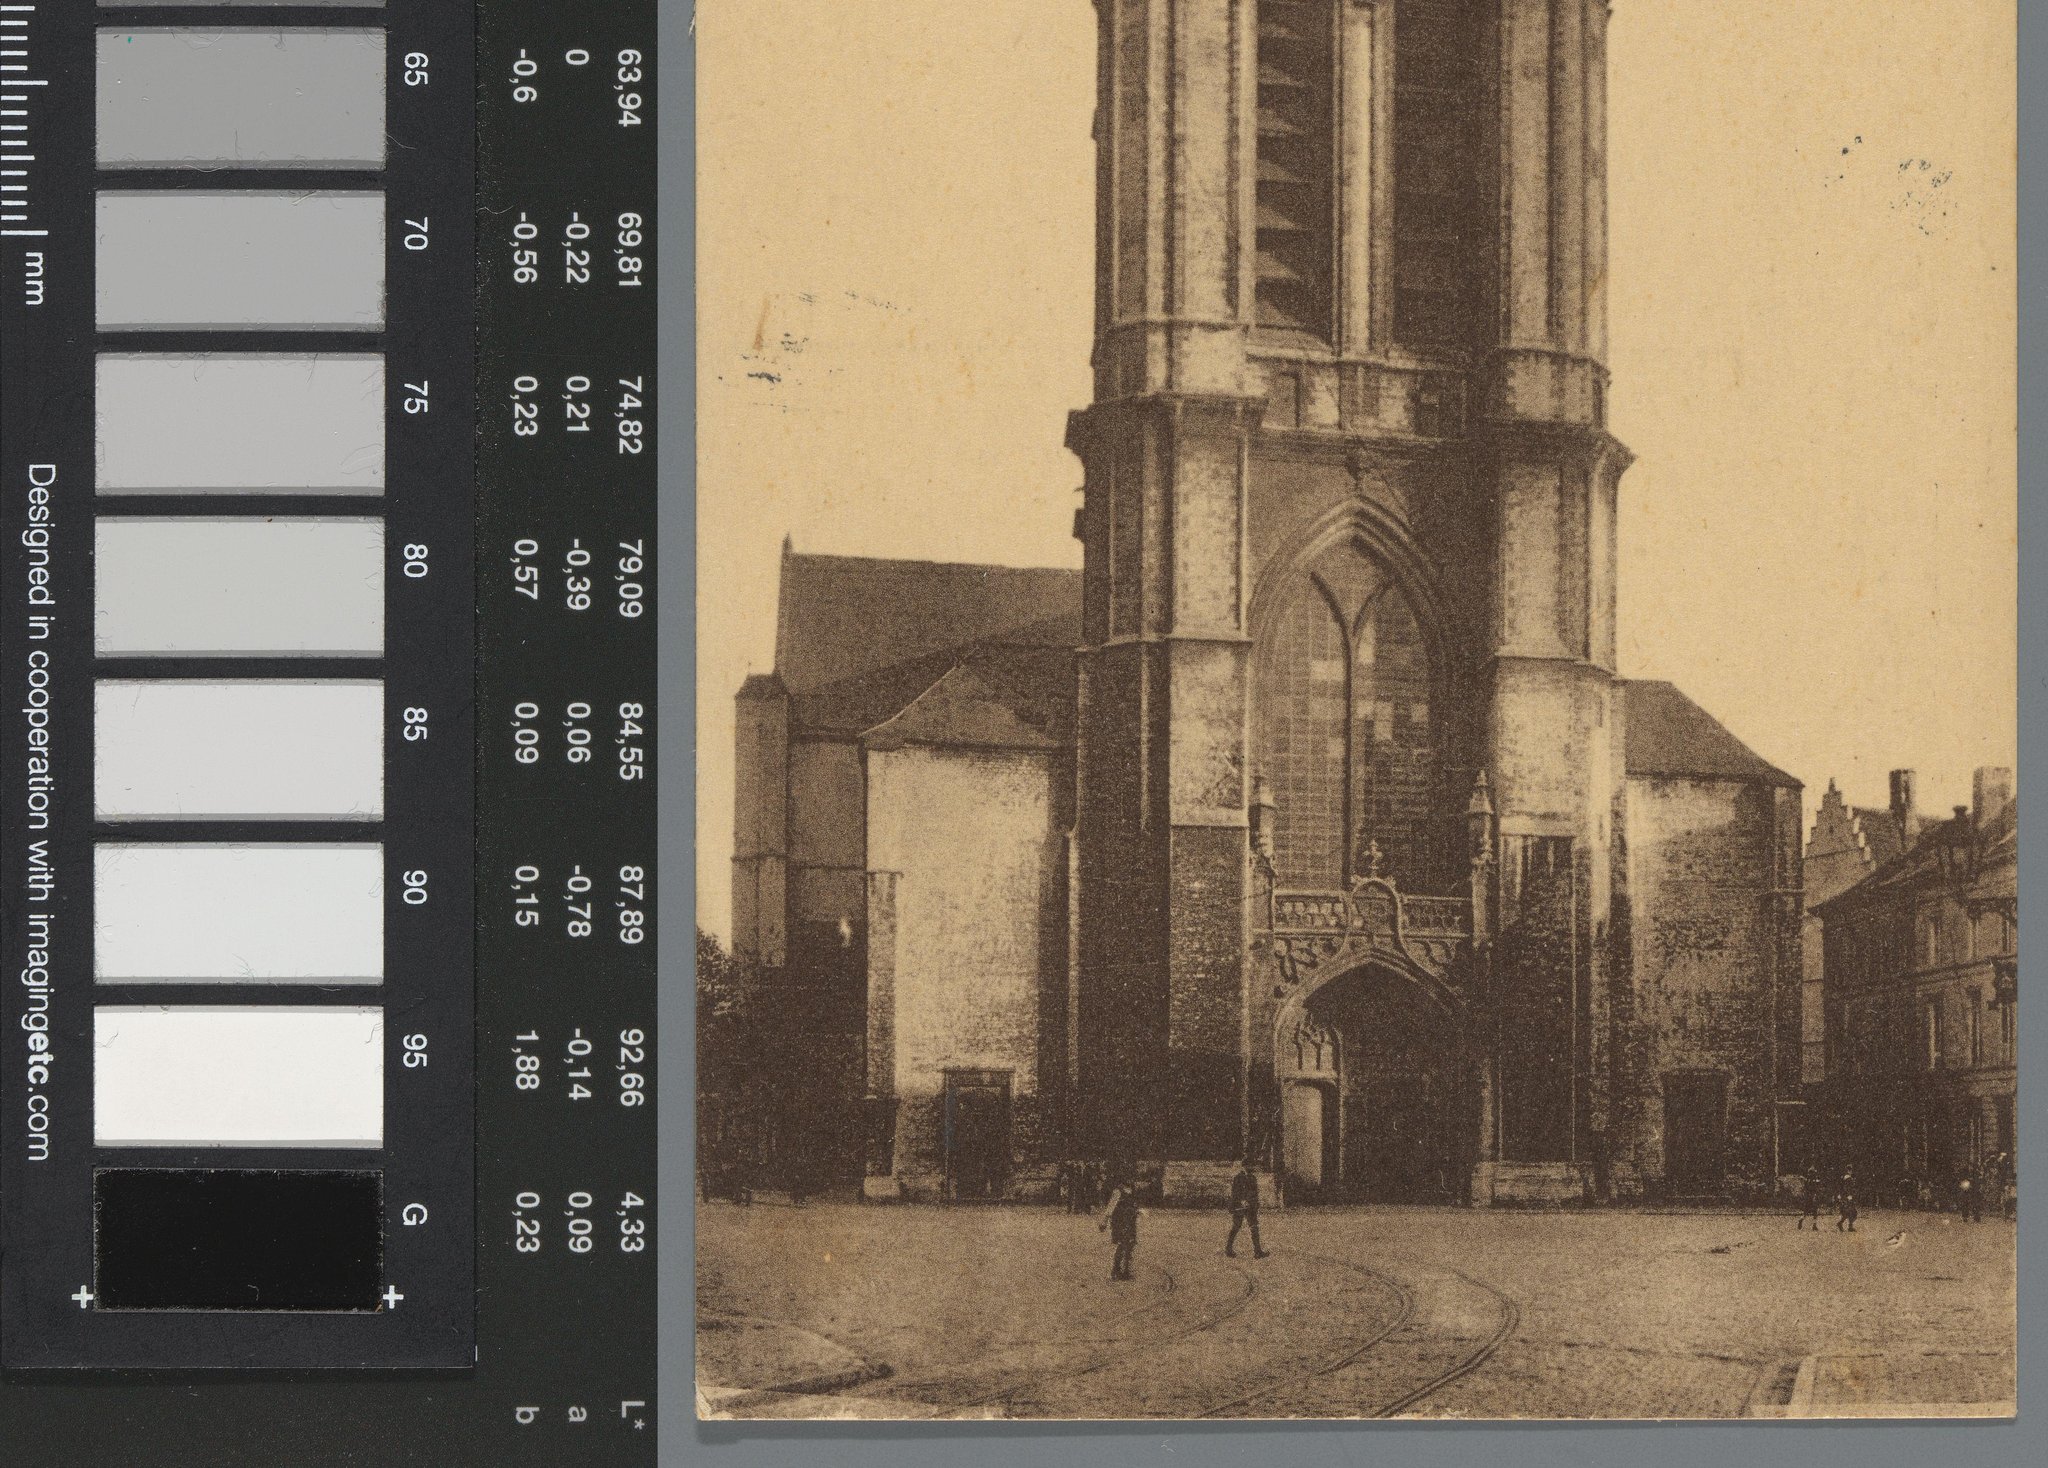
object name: postcard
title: Gand. Eglise Saint-Michel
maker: f. walschaerts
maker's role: publisher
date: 1920-1950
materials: photographic support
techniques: photograph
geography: brussels